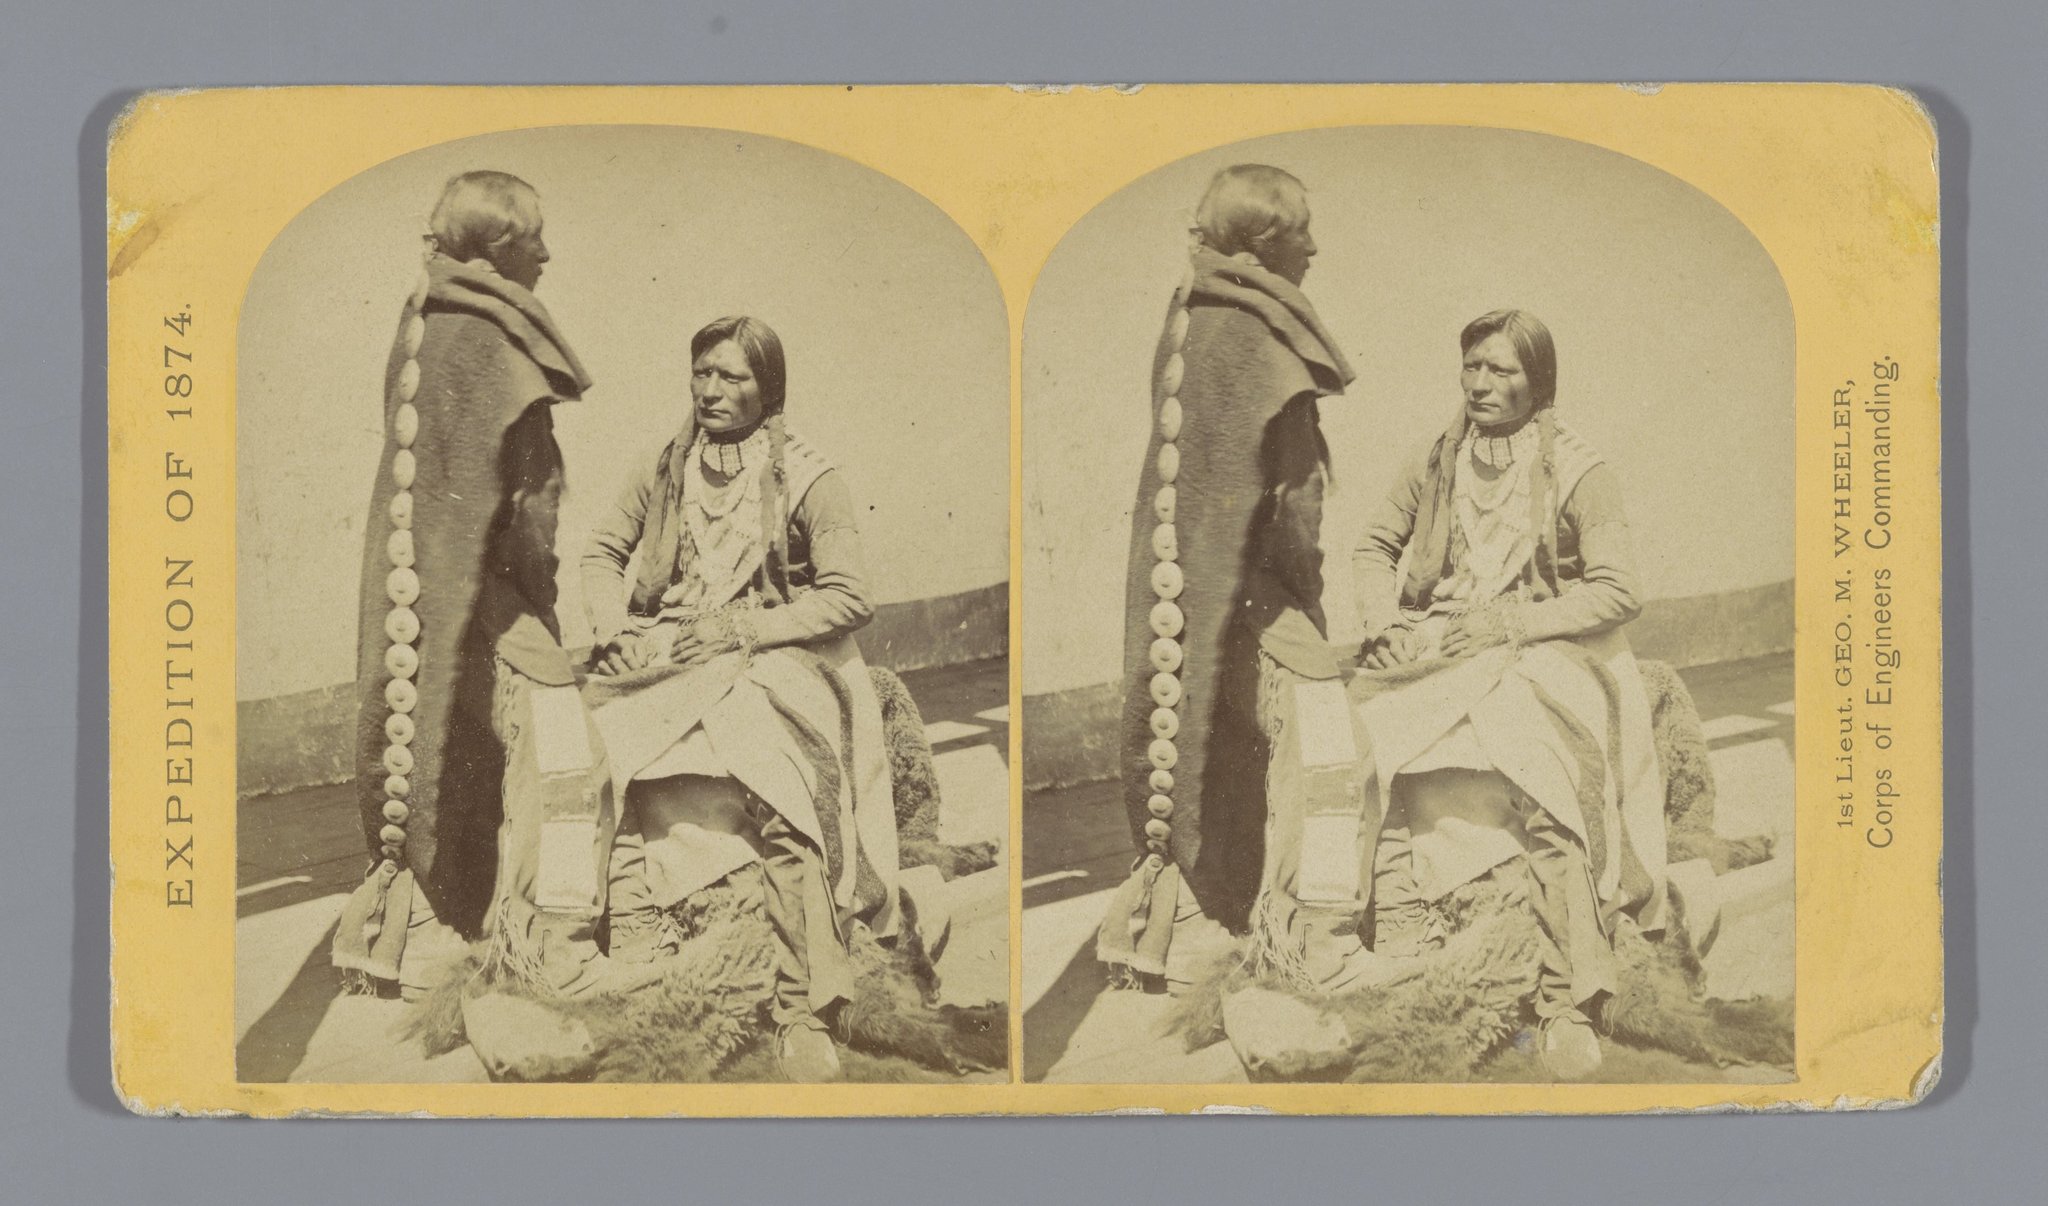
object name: stereograph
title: Twee Kapotamannen van het Ute-volk in New Mexico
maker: timothy h. osullivan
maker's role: fotograaf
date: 1874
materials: cardboard, paper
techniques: albumen print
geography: new mexico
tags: indigenous peoples of north america (ute)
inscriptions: inscription: ‘1st Lieut. Geo. M. Wheeler,/ Corps of Engineers Commanding.’, inscription: ‘War Department, Corps of Engineers, U.S.A./ Geographical/ Explorations and Surveys West of the 100th Meridian.’, number: ‘No. 40.’